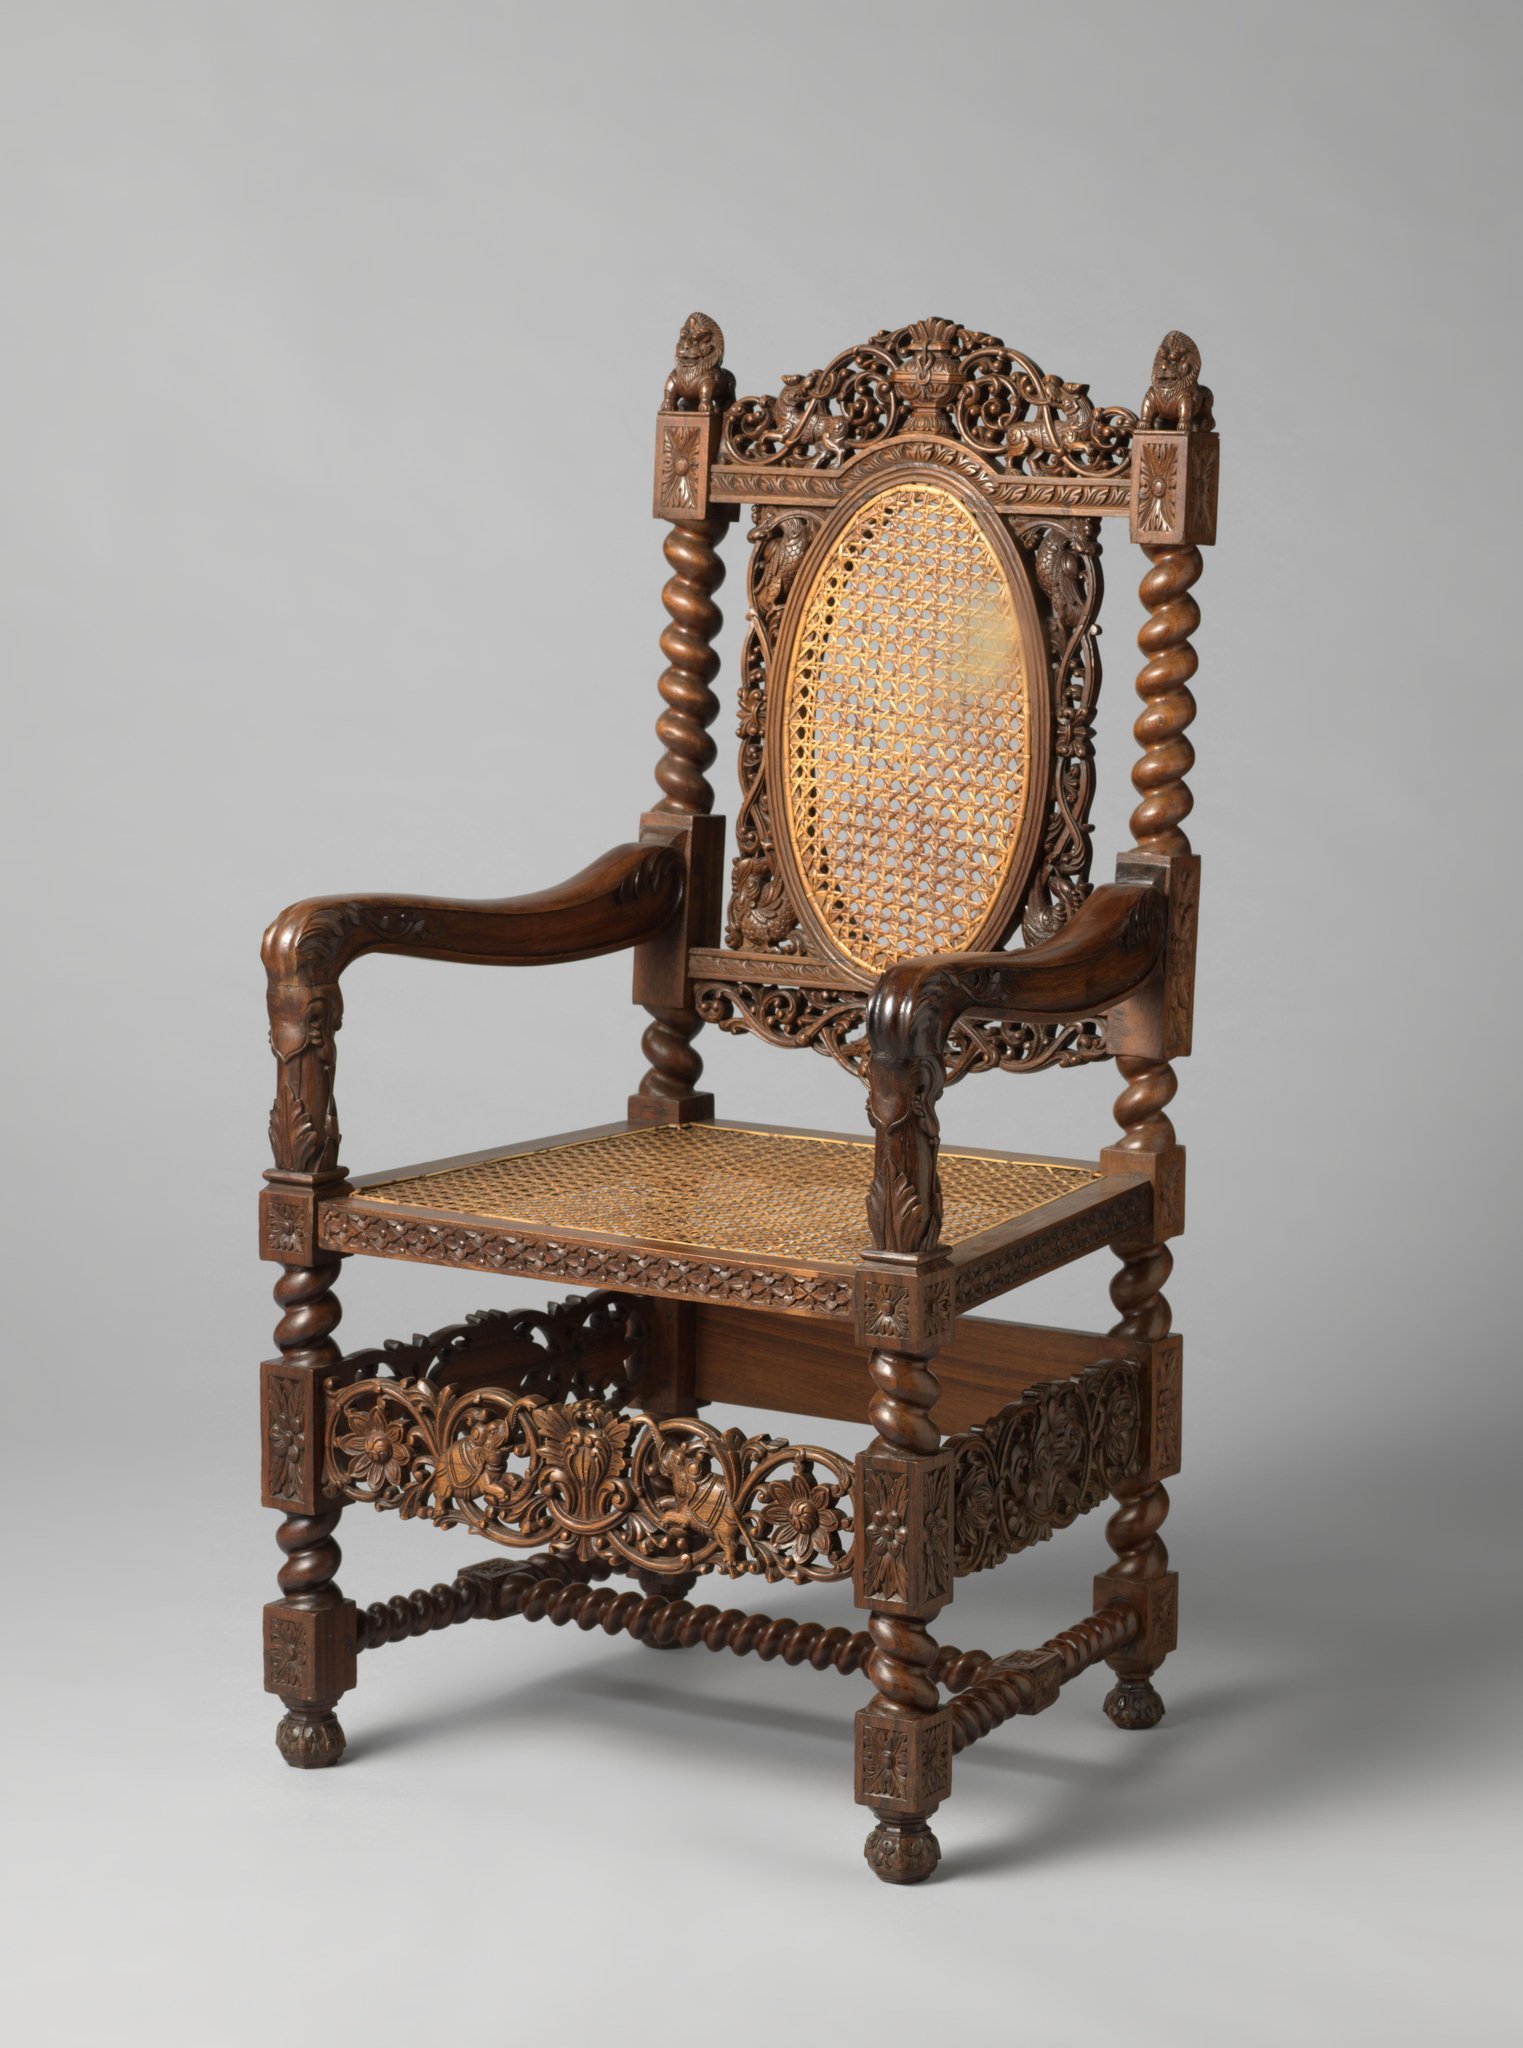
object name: furniture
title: Armstoel met rotan zitting, versierd met rozetten en getordeerde delen, op boogvormige bovenregel een opengewerkte bekroning, armleggers eindigen in ofifantachtige koppen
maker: Anonymous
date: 1700-1725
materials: wood, rattan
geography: indonesia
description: Armchair. Ironwood, cane. Indonesia or Ceylon, c. 1700 - 1725.